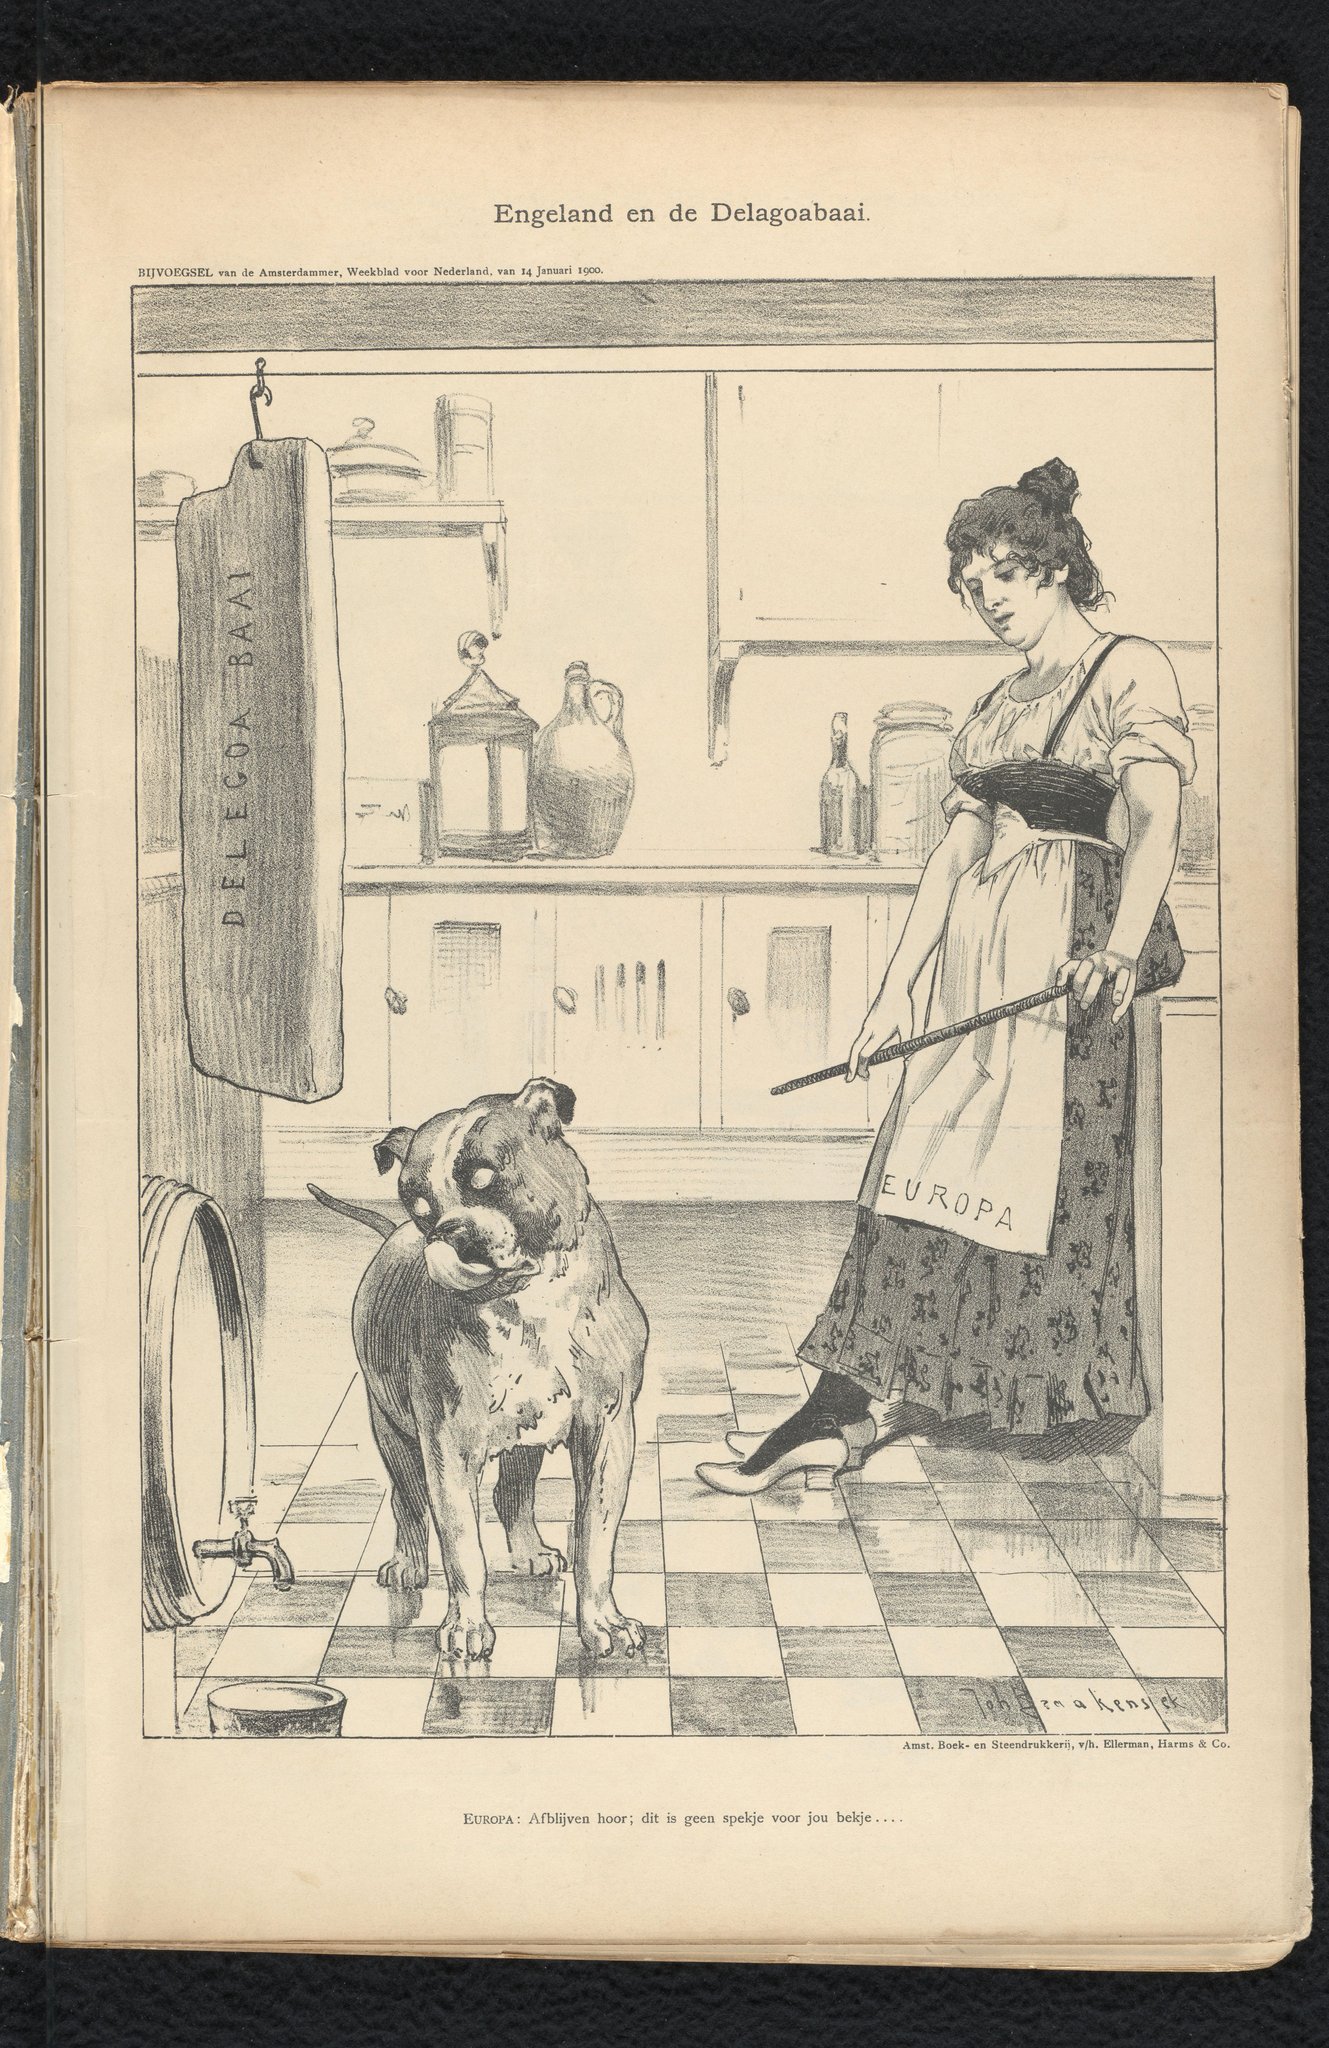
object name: cartoon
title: Engeland en de Delagoabaai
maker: johan braakensiek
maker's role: draughtsman, print maker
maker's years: 1858-1940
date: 1900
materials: paper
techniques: lithograph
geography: netherlands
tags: europe represented allegorically; 'europa' (ripa), personifications of countries, nations, states, districts, etc., kinds of meat, kitchen-maid, kitchen servant, political caricatures and satires, dog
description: Een Engelse bulldog kijkt likkebaardend naar een groot stuk spek 'Delagoa Baai' dat in de keuken hangt. De keukenmeid Europa waarschuwt hem eraf te blijven.